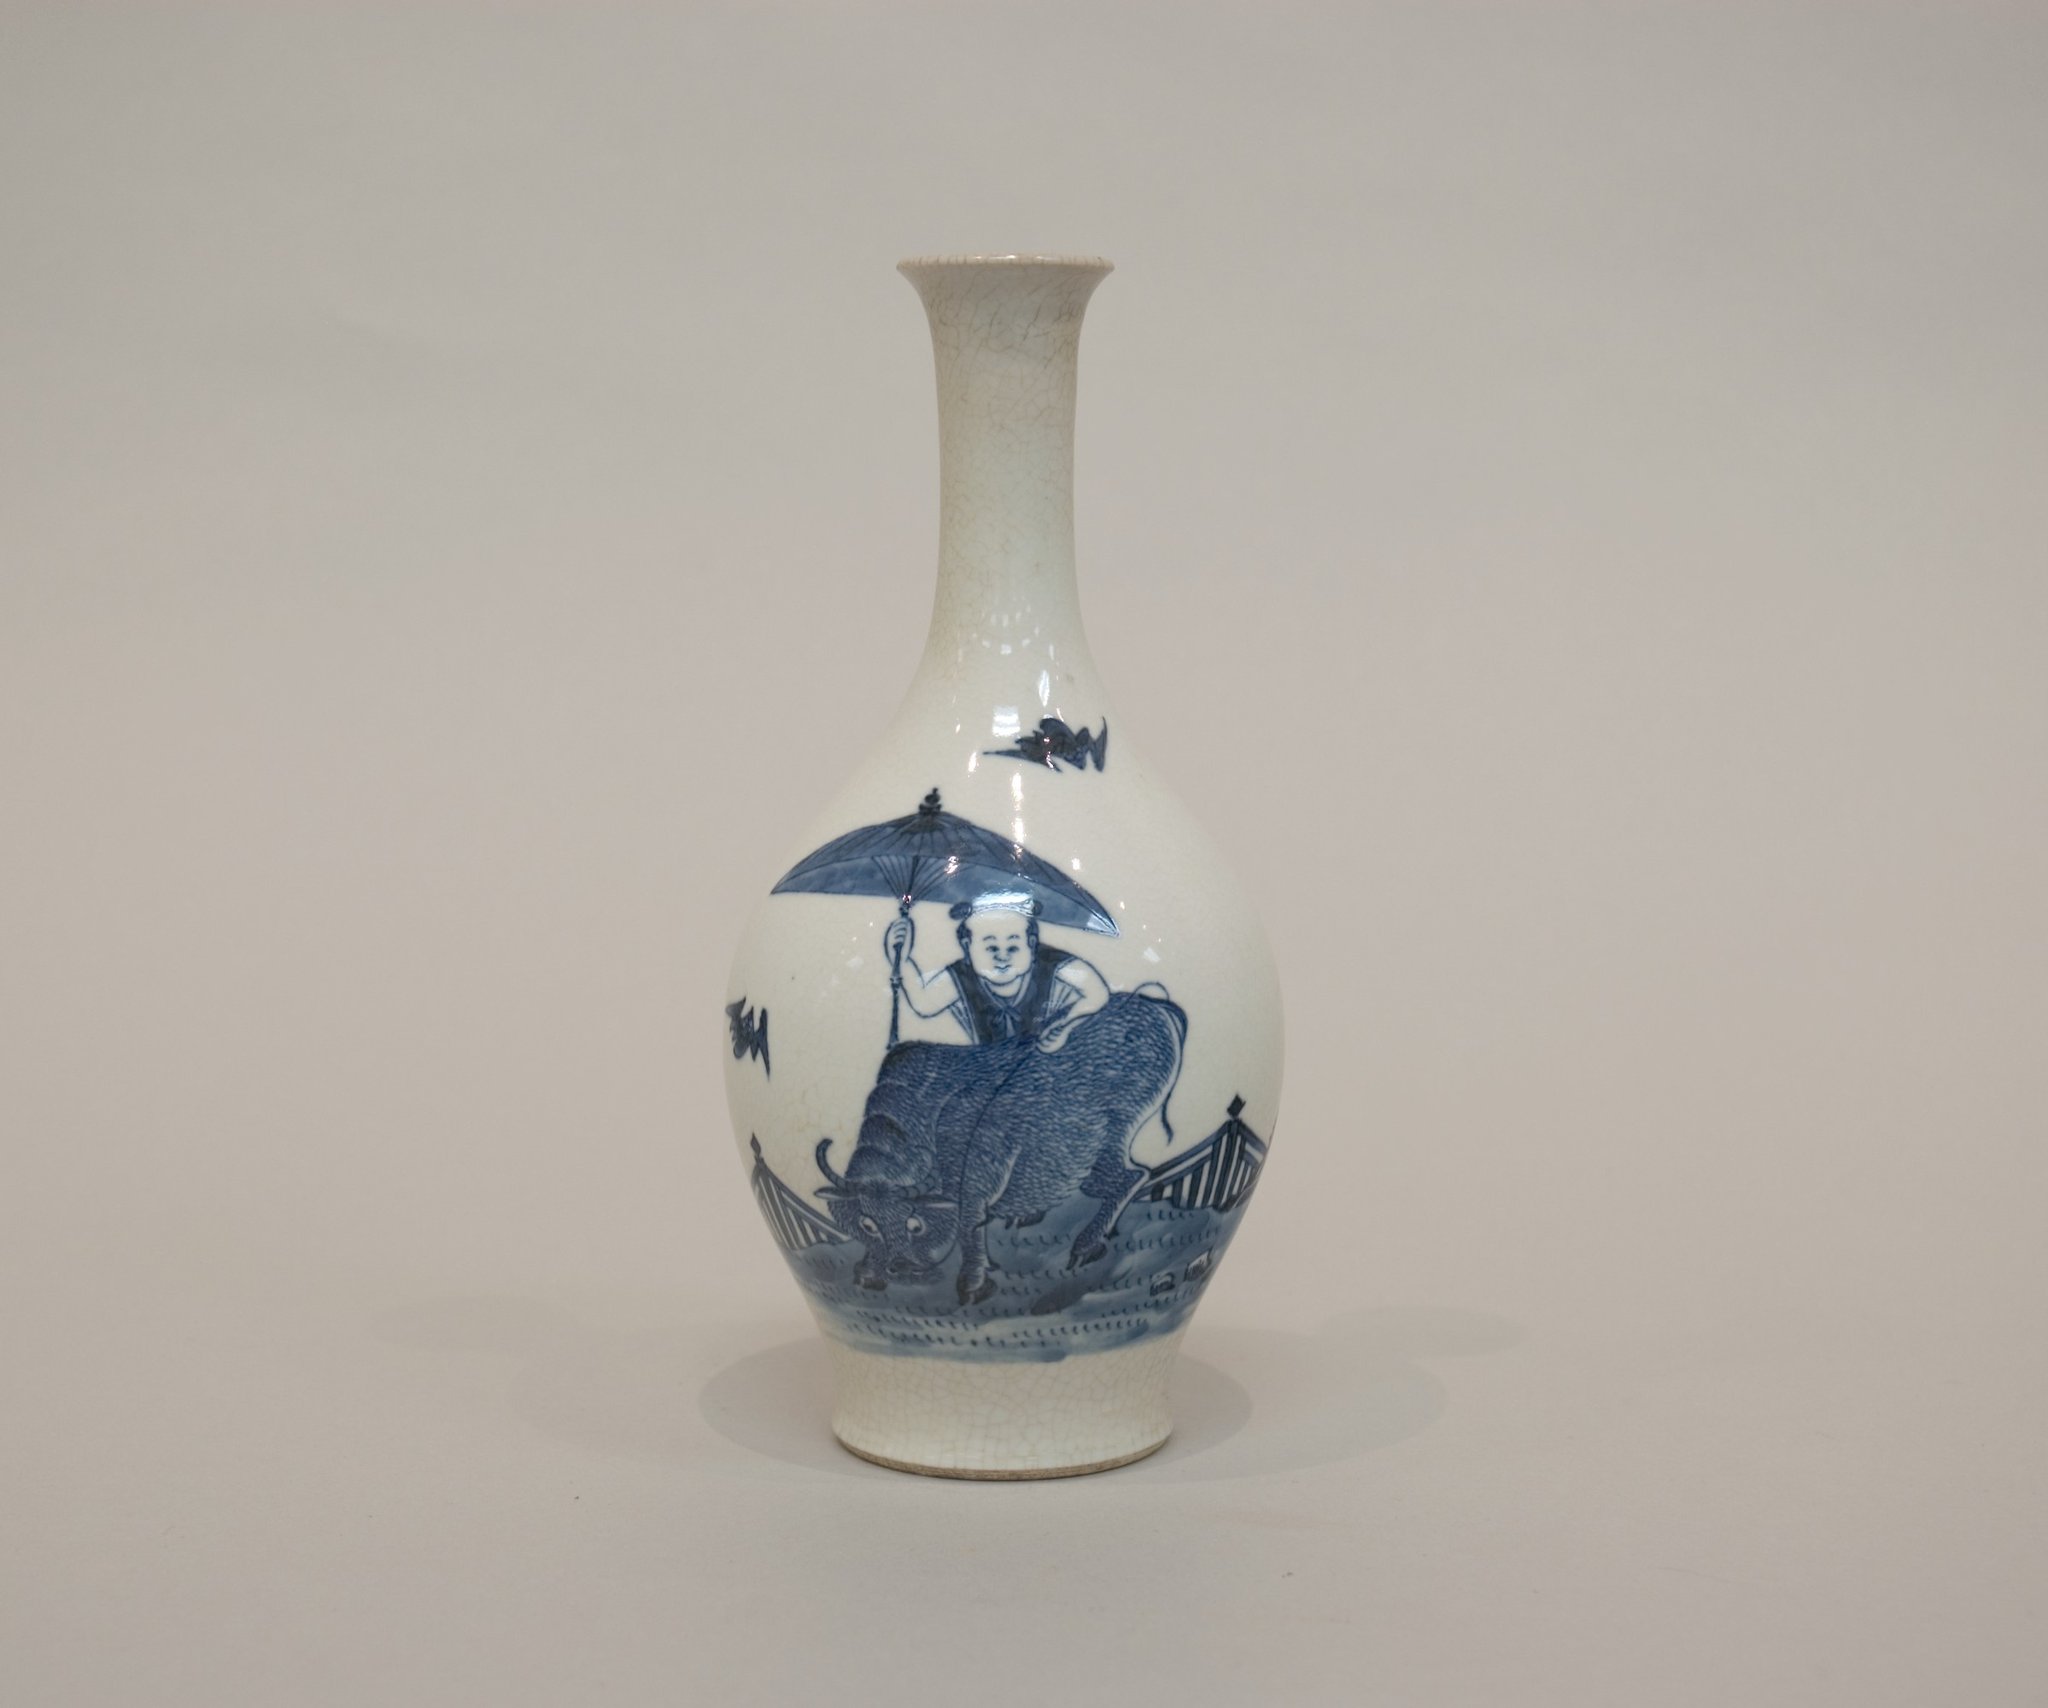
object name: bottle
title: Vase with boy riding an ox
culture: chinese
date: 1701-1800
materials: cobalt, soft paste porcelain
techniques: painting, underglaze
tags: bats,children,ox